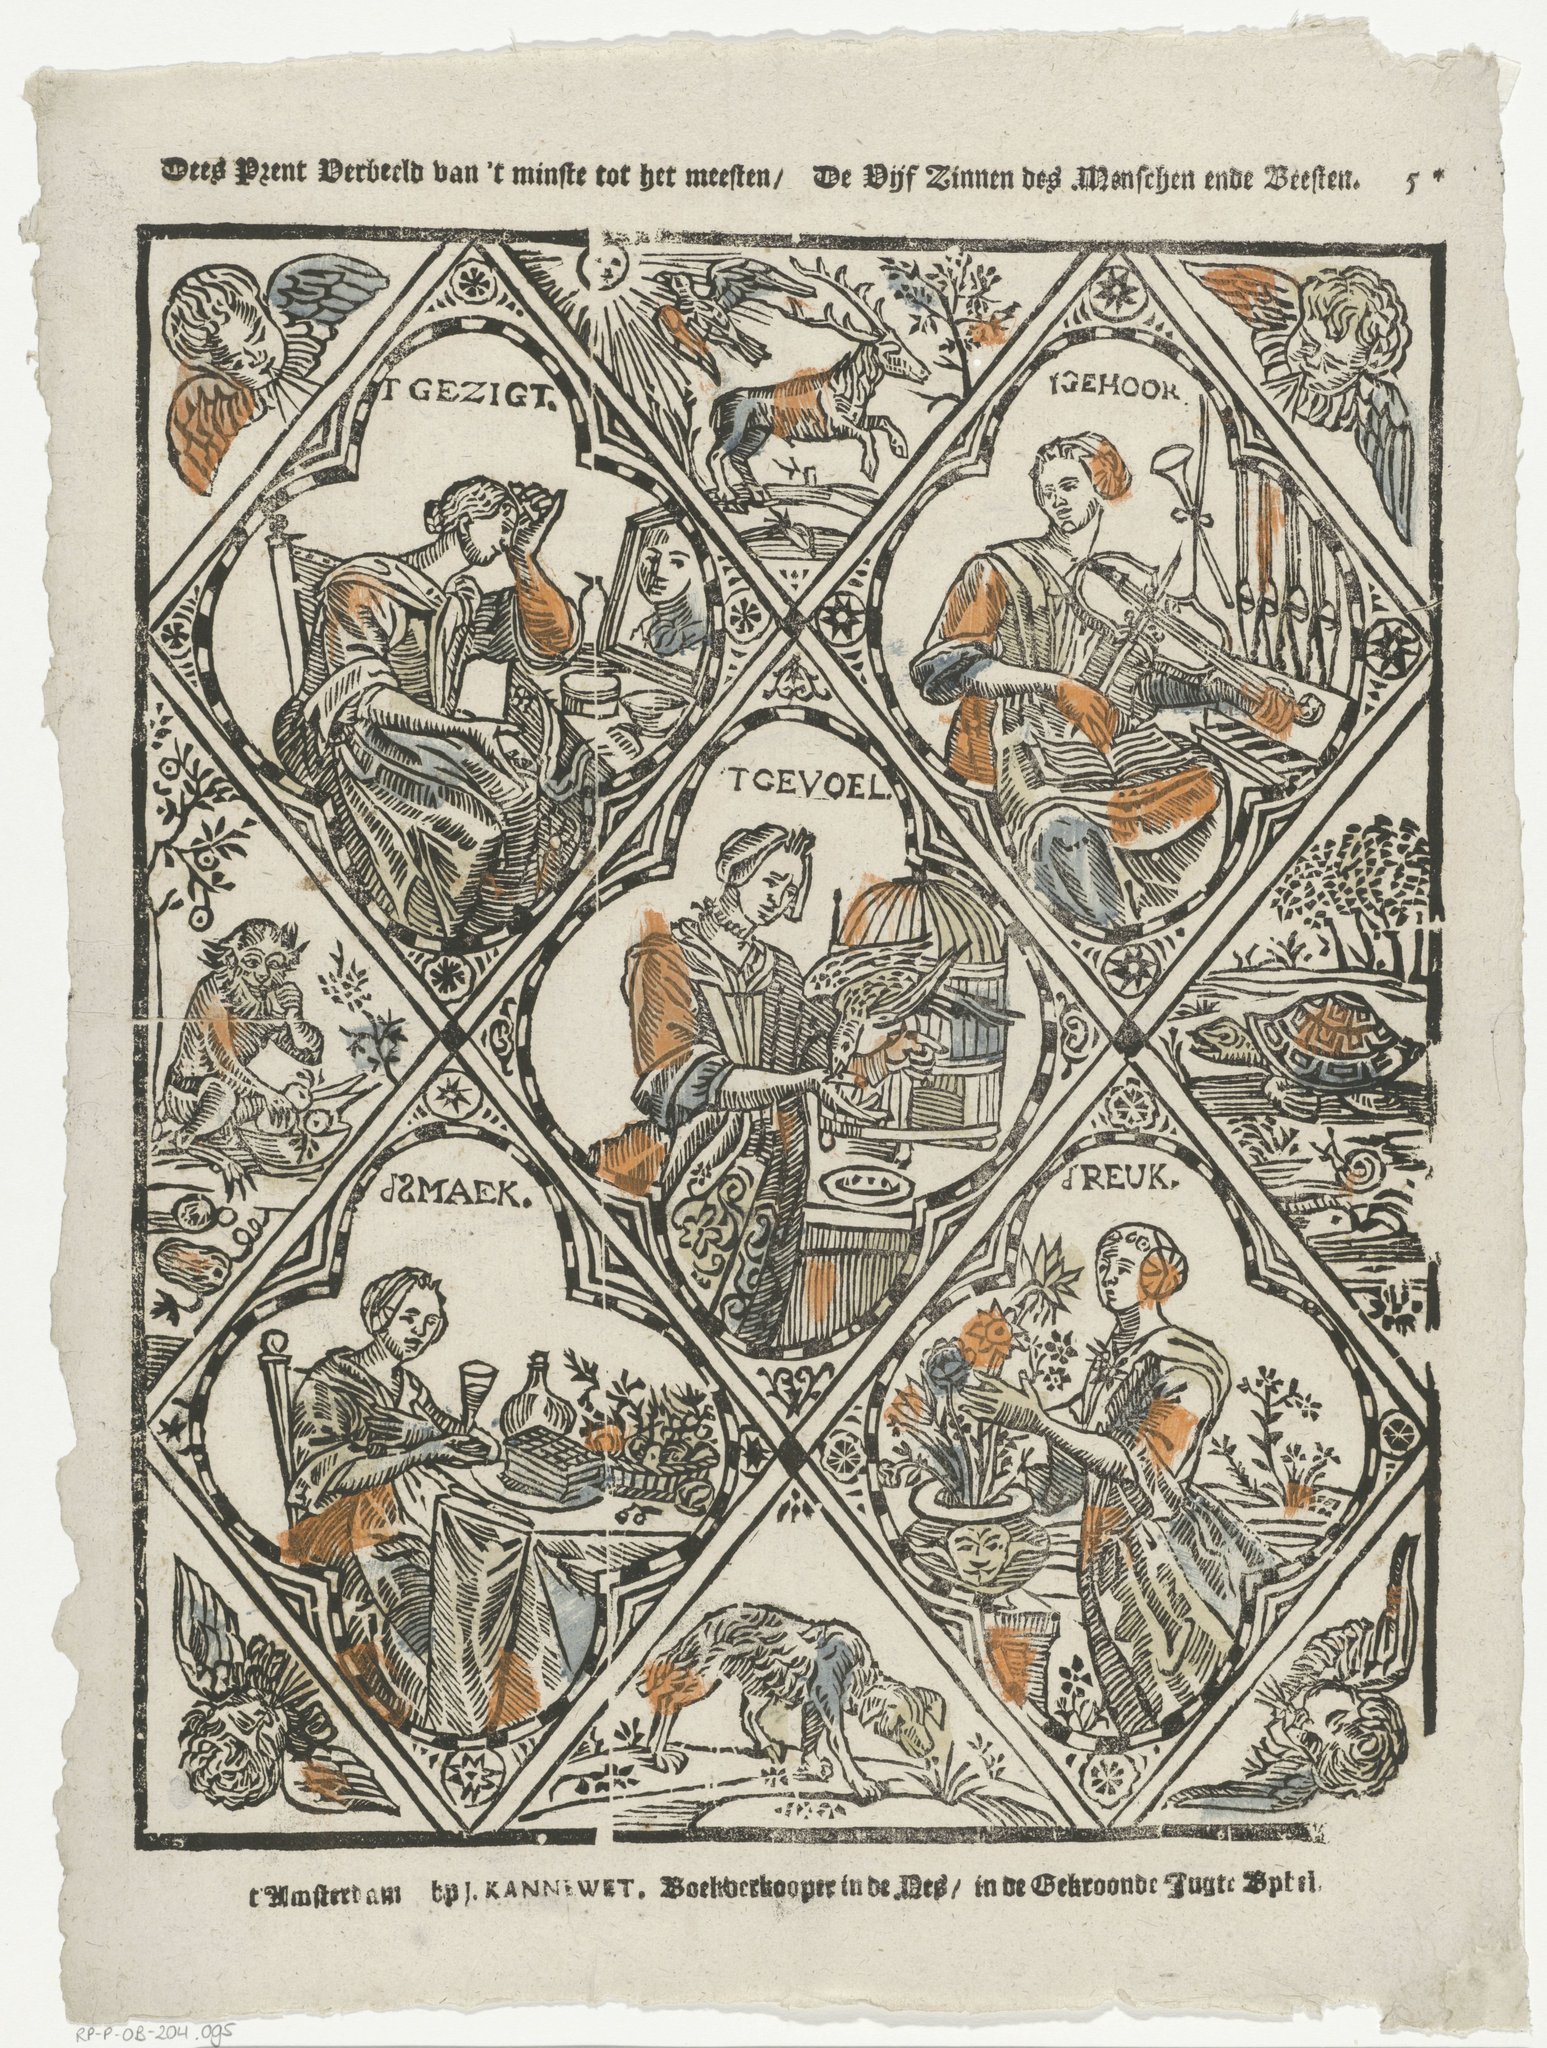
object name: print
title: Dees prent verbeeld van 't minste tot het meesten / De vijf zinnen des menschen ende beesten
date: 1725-1780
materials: paper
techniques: colour, letterpress printing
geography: amsterdam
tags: hoofed animals: deer, tortoises, turtles, monkeys, apes, the (five) senses, cupids: 'amores', 'amoretti', 'putti', the (five) senses - aa - female human figure, dog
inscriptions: collector's mark: Lugt 2760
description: Blad met voorstellingen van personificaties van de vijf zintuigen, gevat in ruiten. Rondom voorstellingen van een hert, een schildpad, een hond, een aap. In de vier hoeken blazende cherubijnen. Genummerd rechtsboven: 5*.